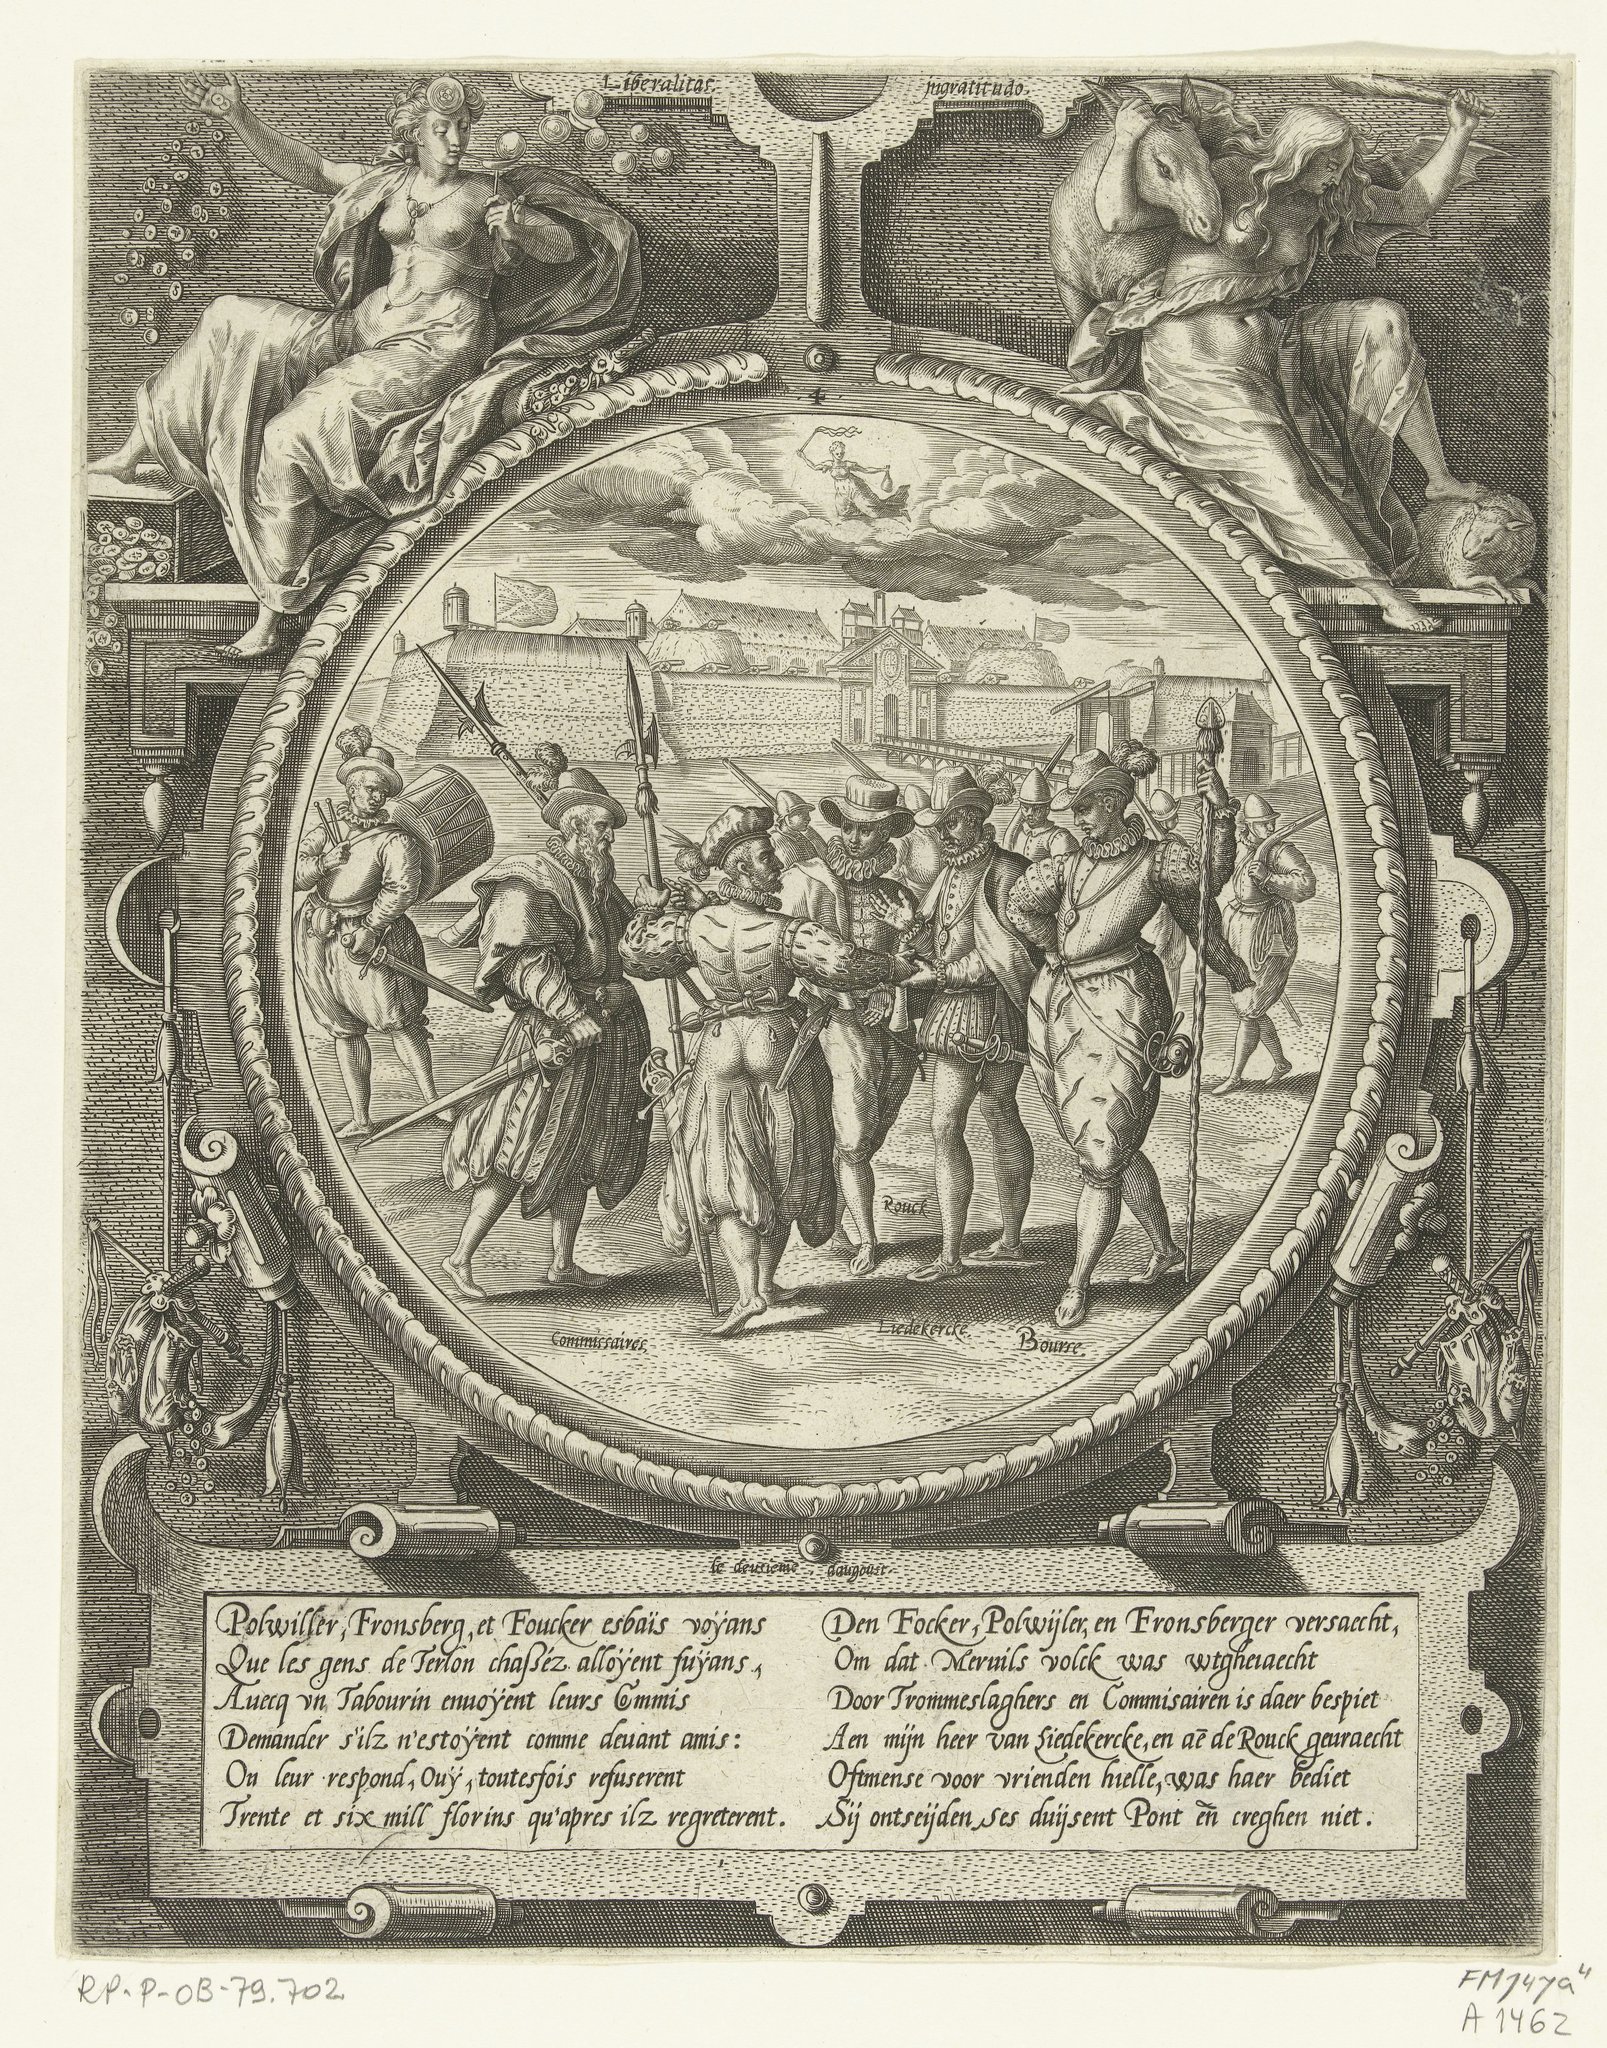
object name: print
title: Medaillons met de verovering van de citadel van Antwerpen in 1577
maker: wierix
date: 1578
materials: paper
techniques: engraving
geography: southern netherlands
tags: negotiations for truce, ingratitude; 'ingratitudine' (ripa), generosity, liberality; 'generosità', 'liberalità' (ripa), punishment; 'castigo', 'pena', 'punitione' (ripa)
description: Onderhandelingen tussen Liedekercke, Roeck en Bourse en de Duitse commandanten over een afkoopsom voor het vertrek van het Duitse garnizoen, 2 augustus 1577. Groep mannen staande in overleg, op de achtergrond de citadel. In de wolken de personificatie van Gods bestraffing. Voorstelling in een rond medaillon met ornamentele allegorische omlijsting met bovenaan de zittende vrouwelijke personificaties van Vrijgevigheid (Liberalitas) en Ondankbaarheid (Ingratitudo). Onderaan een cartouche met 2 verzen van elk 6 regels in het Frans en Nederlands.